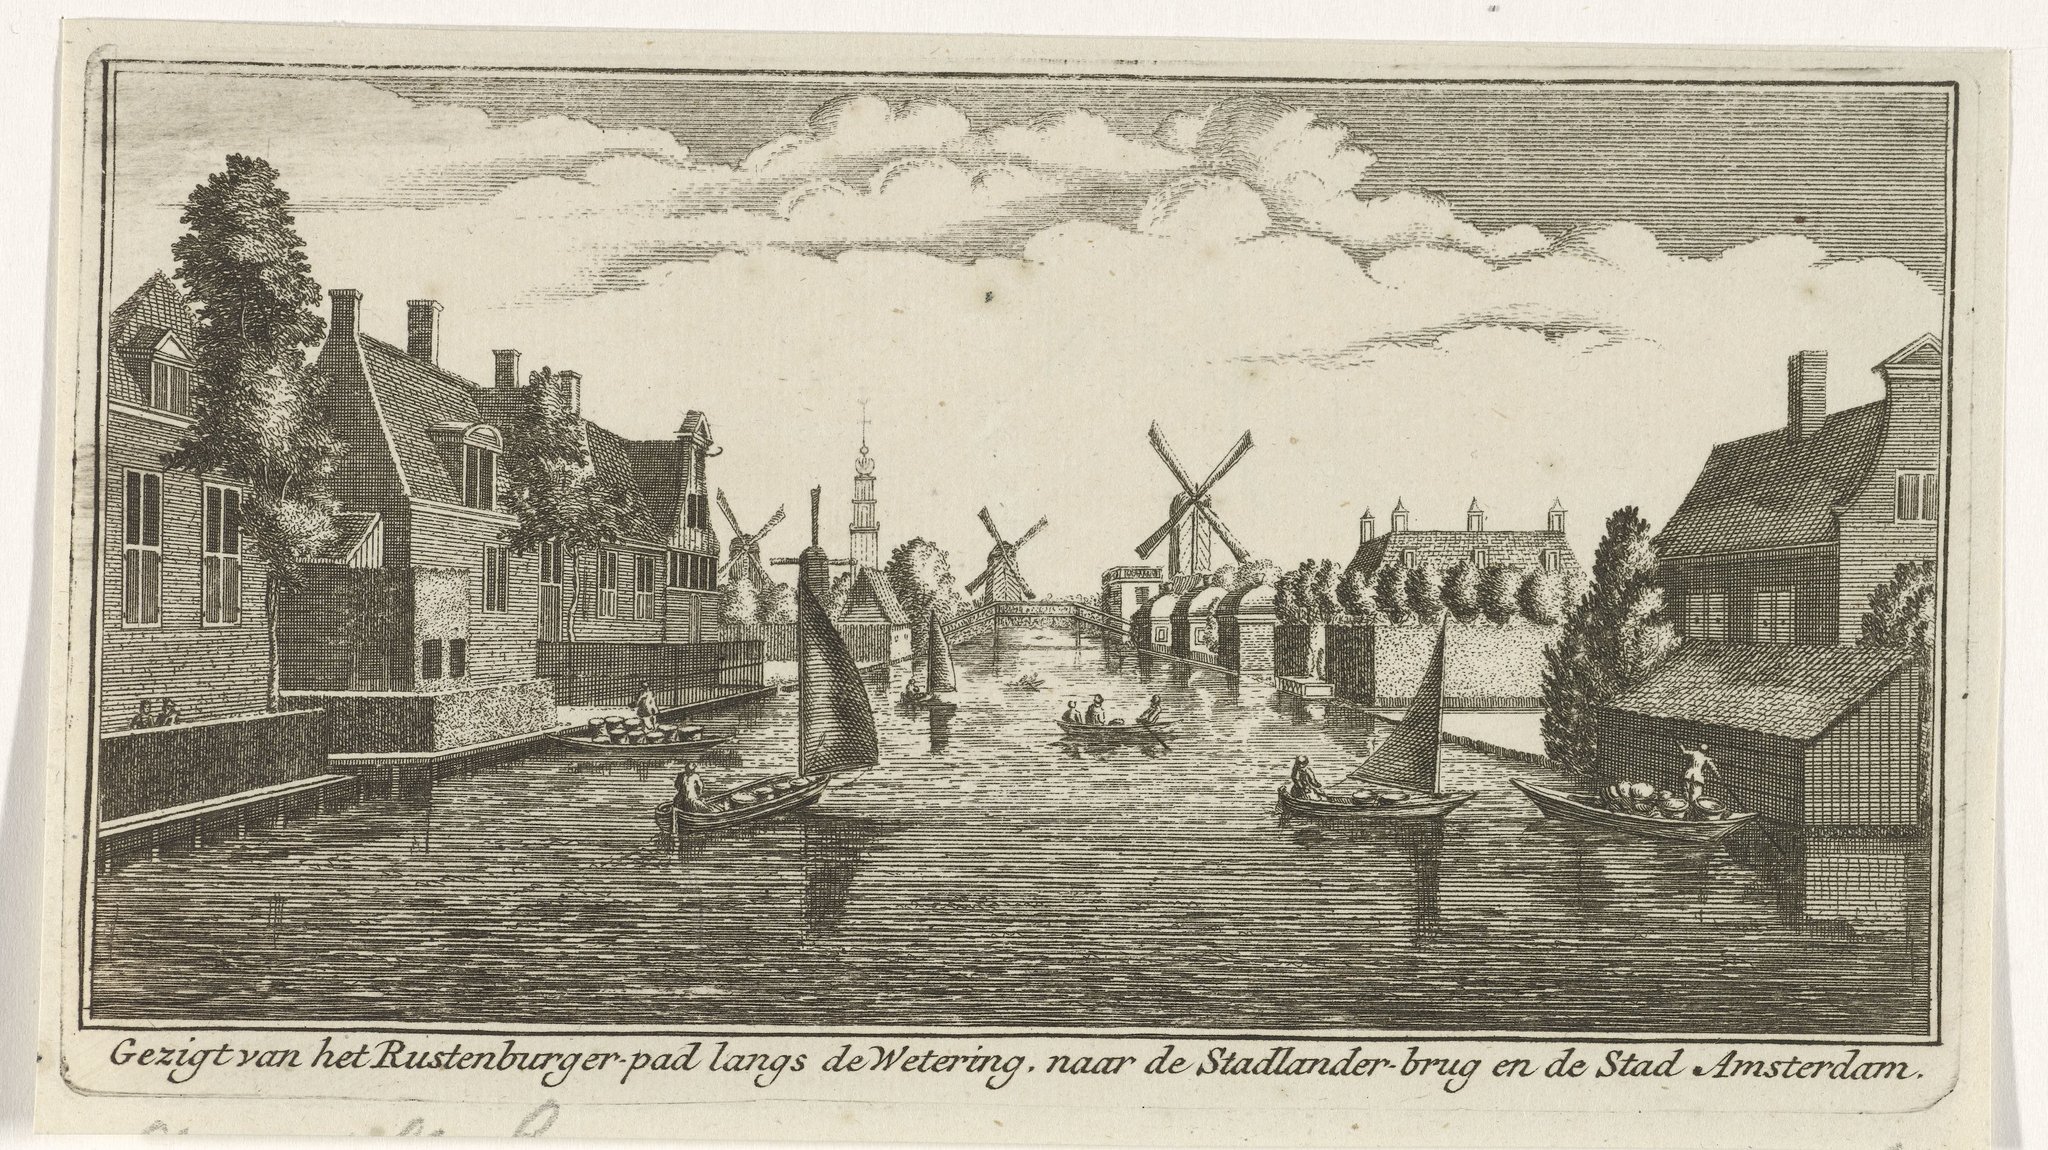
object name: print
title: Gezigt van het Rustenburger-pad langs de Wetering, naar de Stadlander-brug en de Stad Amsterdam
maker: gerardus condet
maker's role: print maker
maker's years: 1715-1764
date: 1725-1764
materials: paper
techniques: etching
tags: sailing-ship, sailing-boat, garden, rowing-boat, canoe, etc., bridge, windmill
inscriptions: collector's mark: Lugt 2228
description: Gezicht vanaf het Rustenburgerpad op de wetering en de Stadlanderbrug, met in de verte Amsterdam. Links en rechts van de wetering staan huizen, waarvan enkele een aangrenzende tuin hebben. Aan de oevers van de wetering zijn diverse boten aangemeerd, en in het midden van het water zeilen scheepjes met lading.